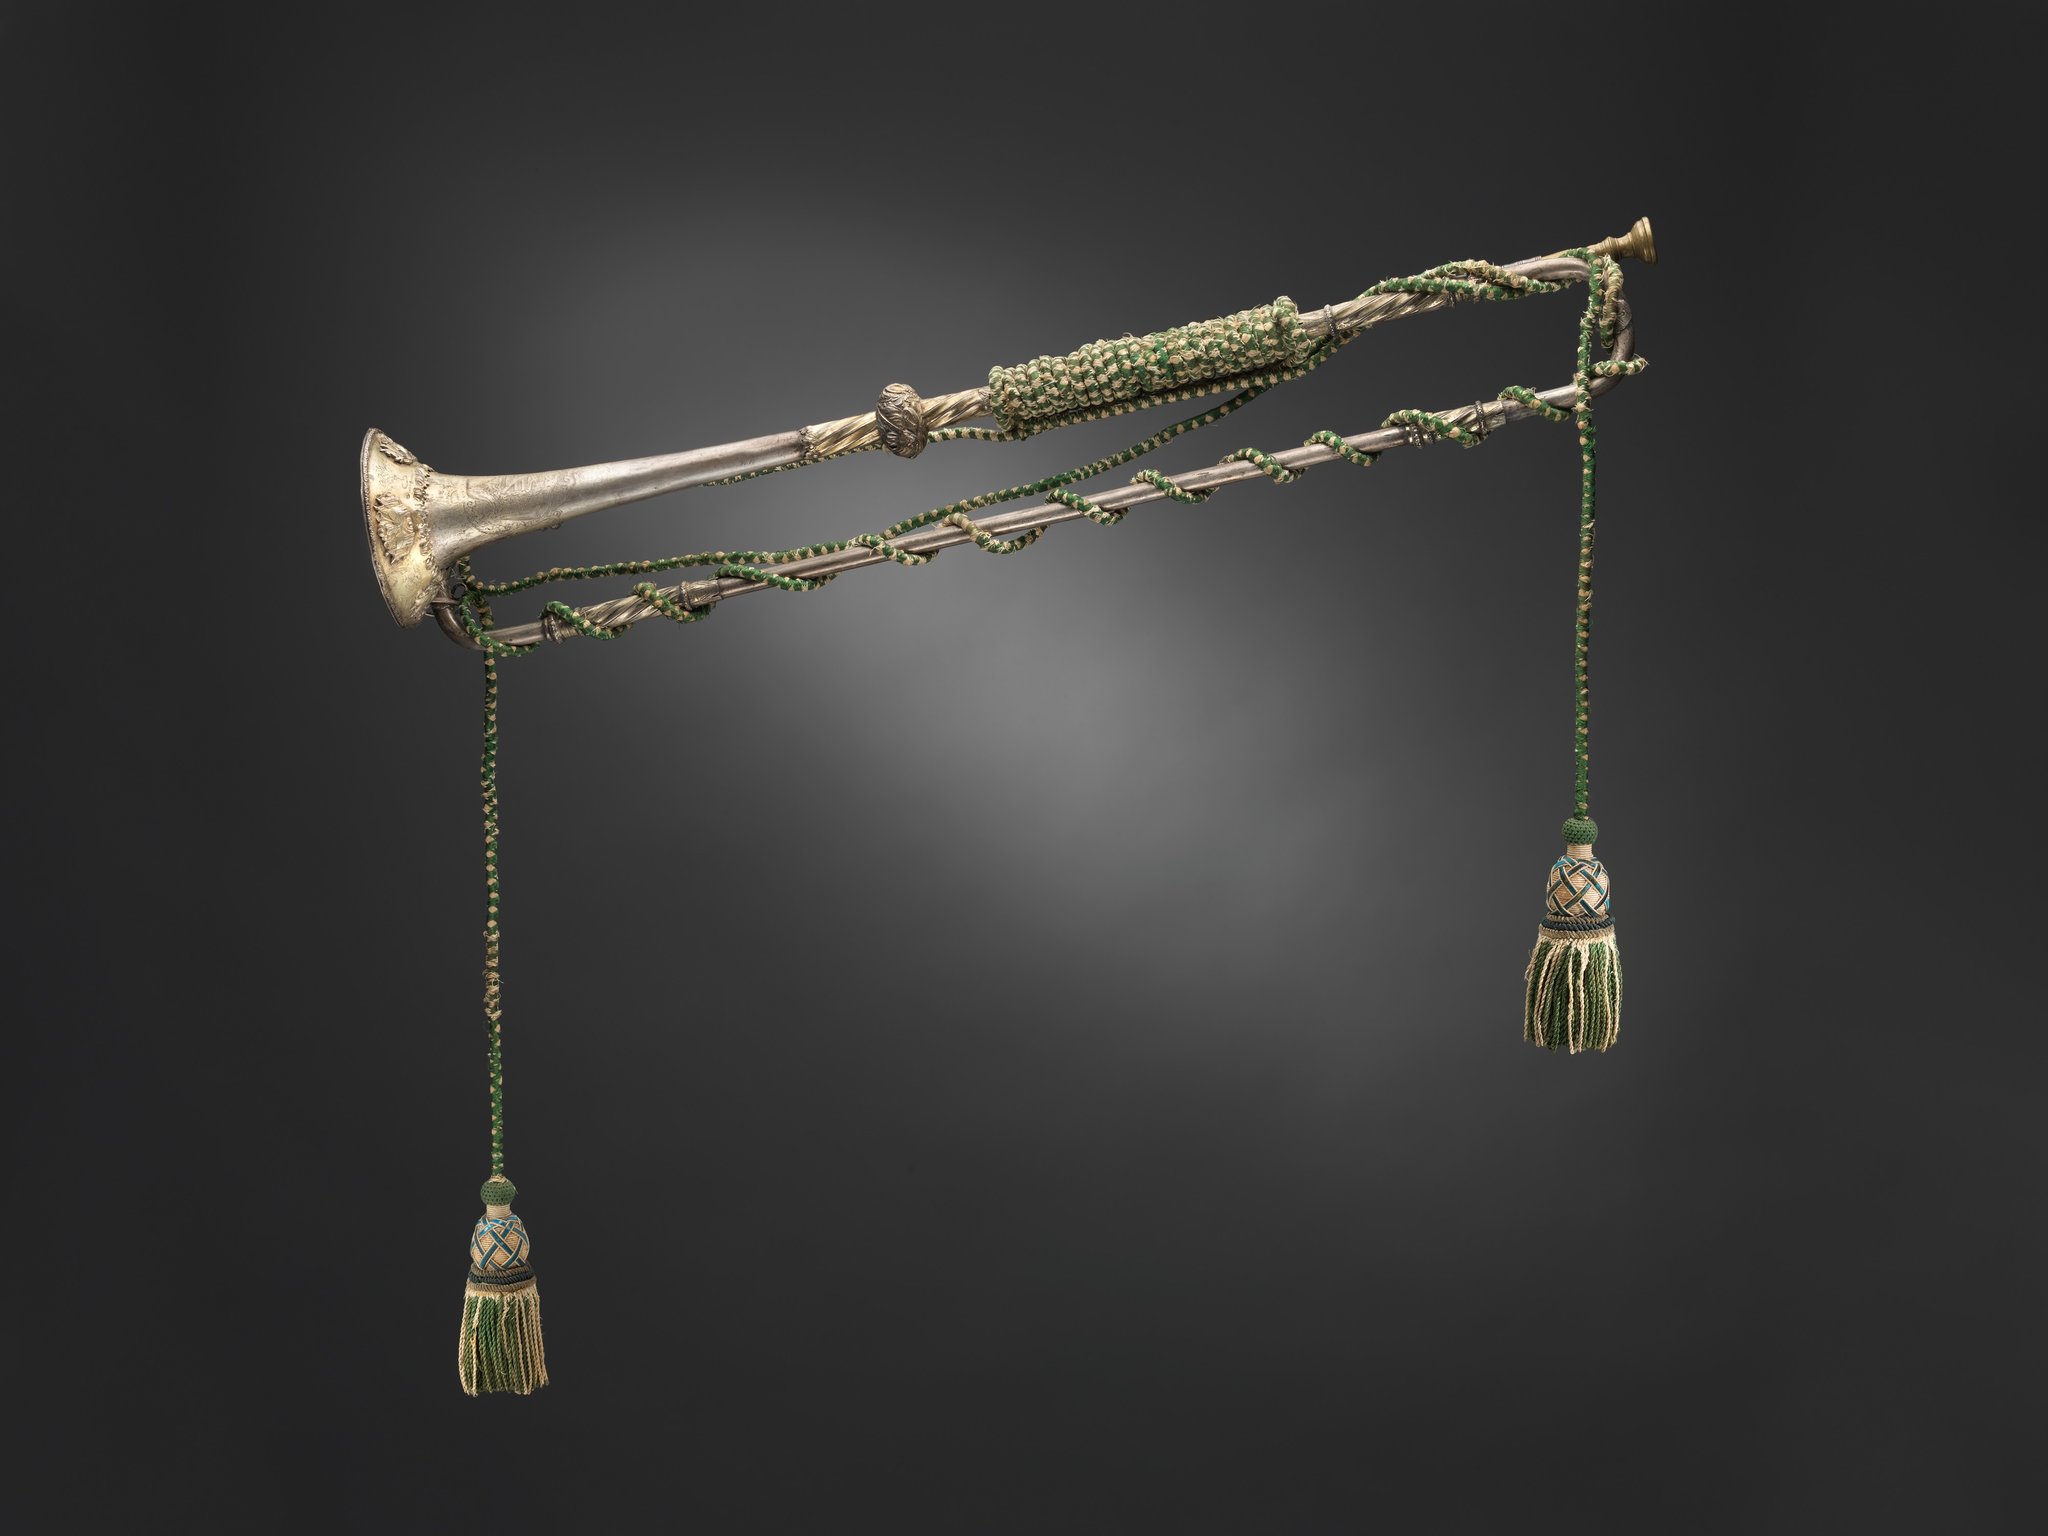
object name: natural trumpet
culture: german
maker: johann wilhelm haas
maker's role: maker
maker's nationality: german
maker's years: 1649-1723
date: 1700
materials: silver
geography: germany